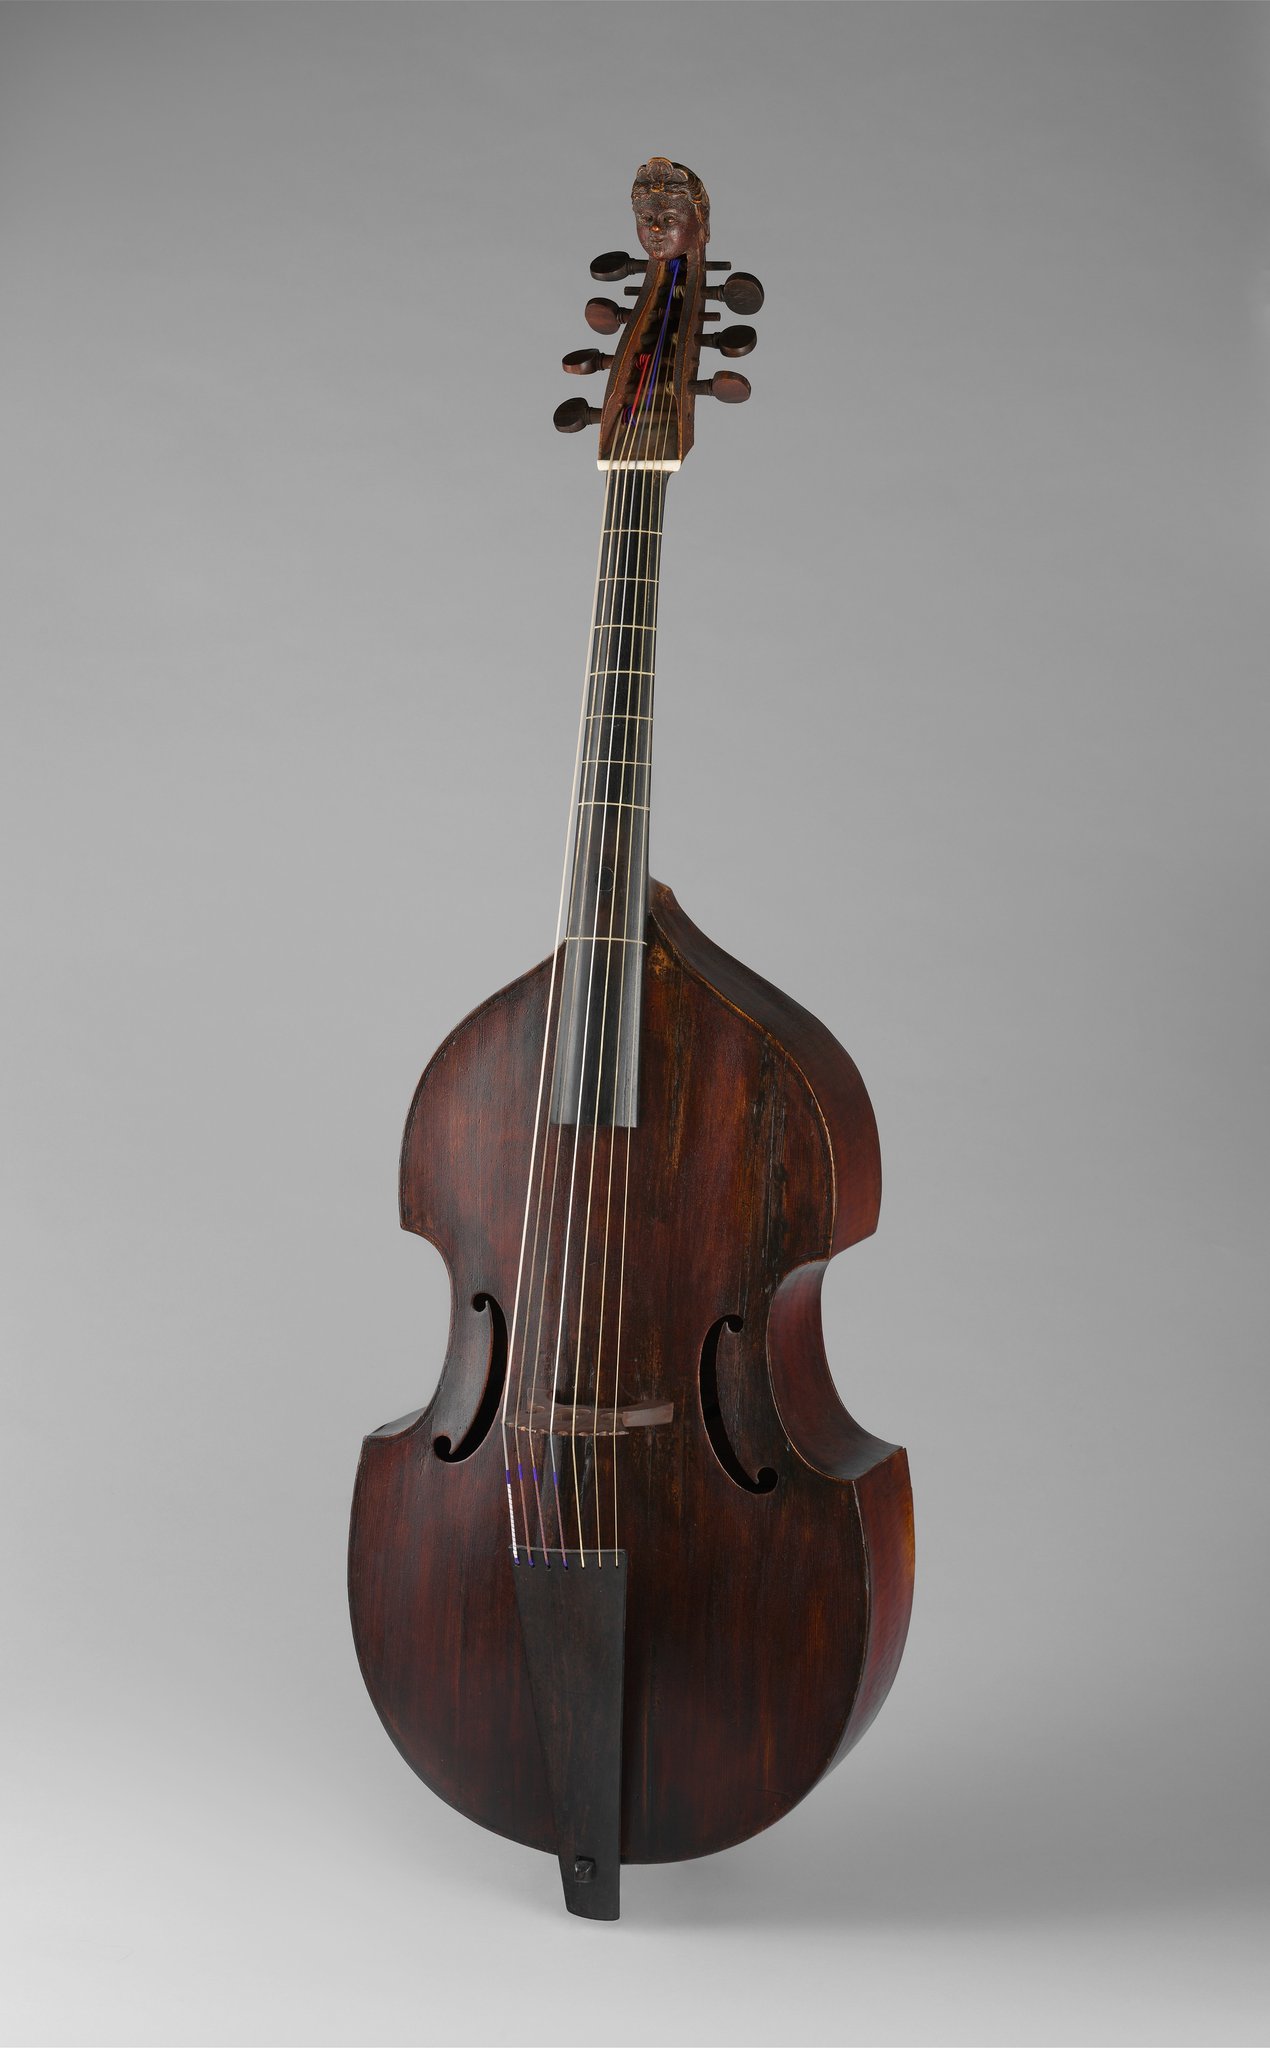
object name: seven string bass viol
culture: french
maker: nicolas bertrand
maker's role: maker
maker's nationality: french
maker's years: 1686-1735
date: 1720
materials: wood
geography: france